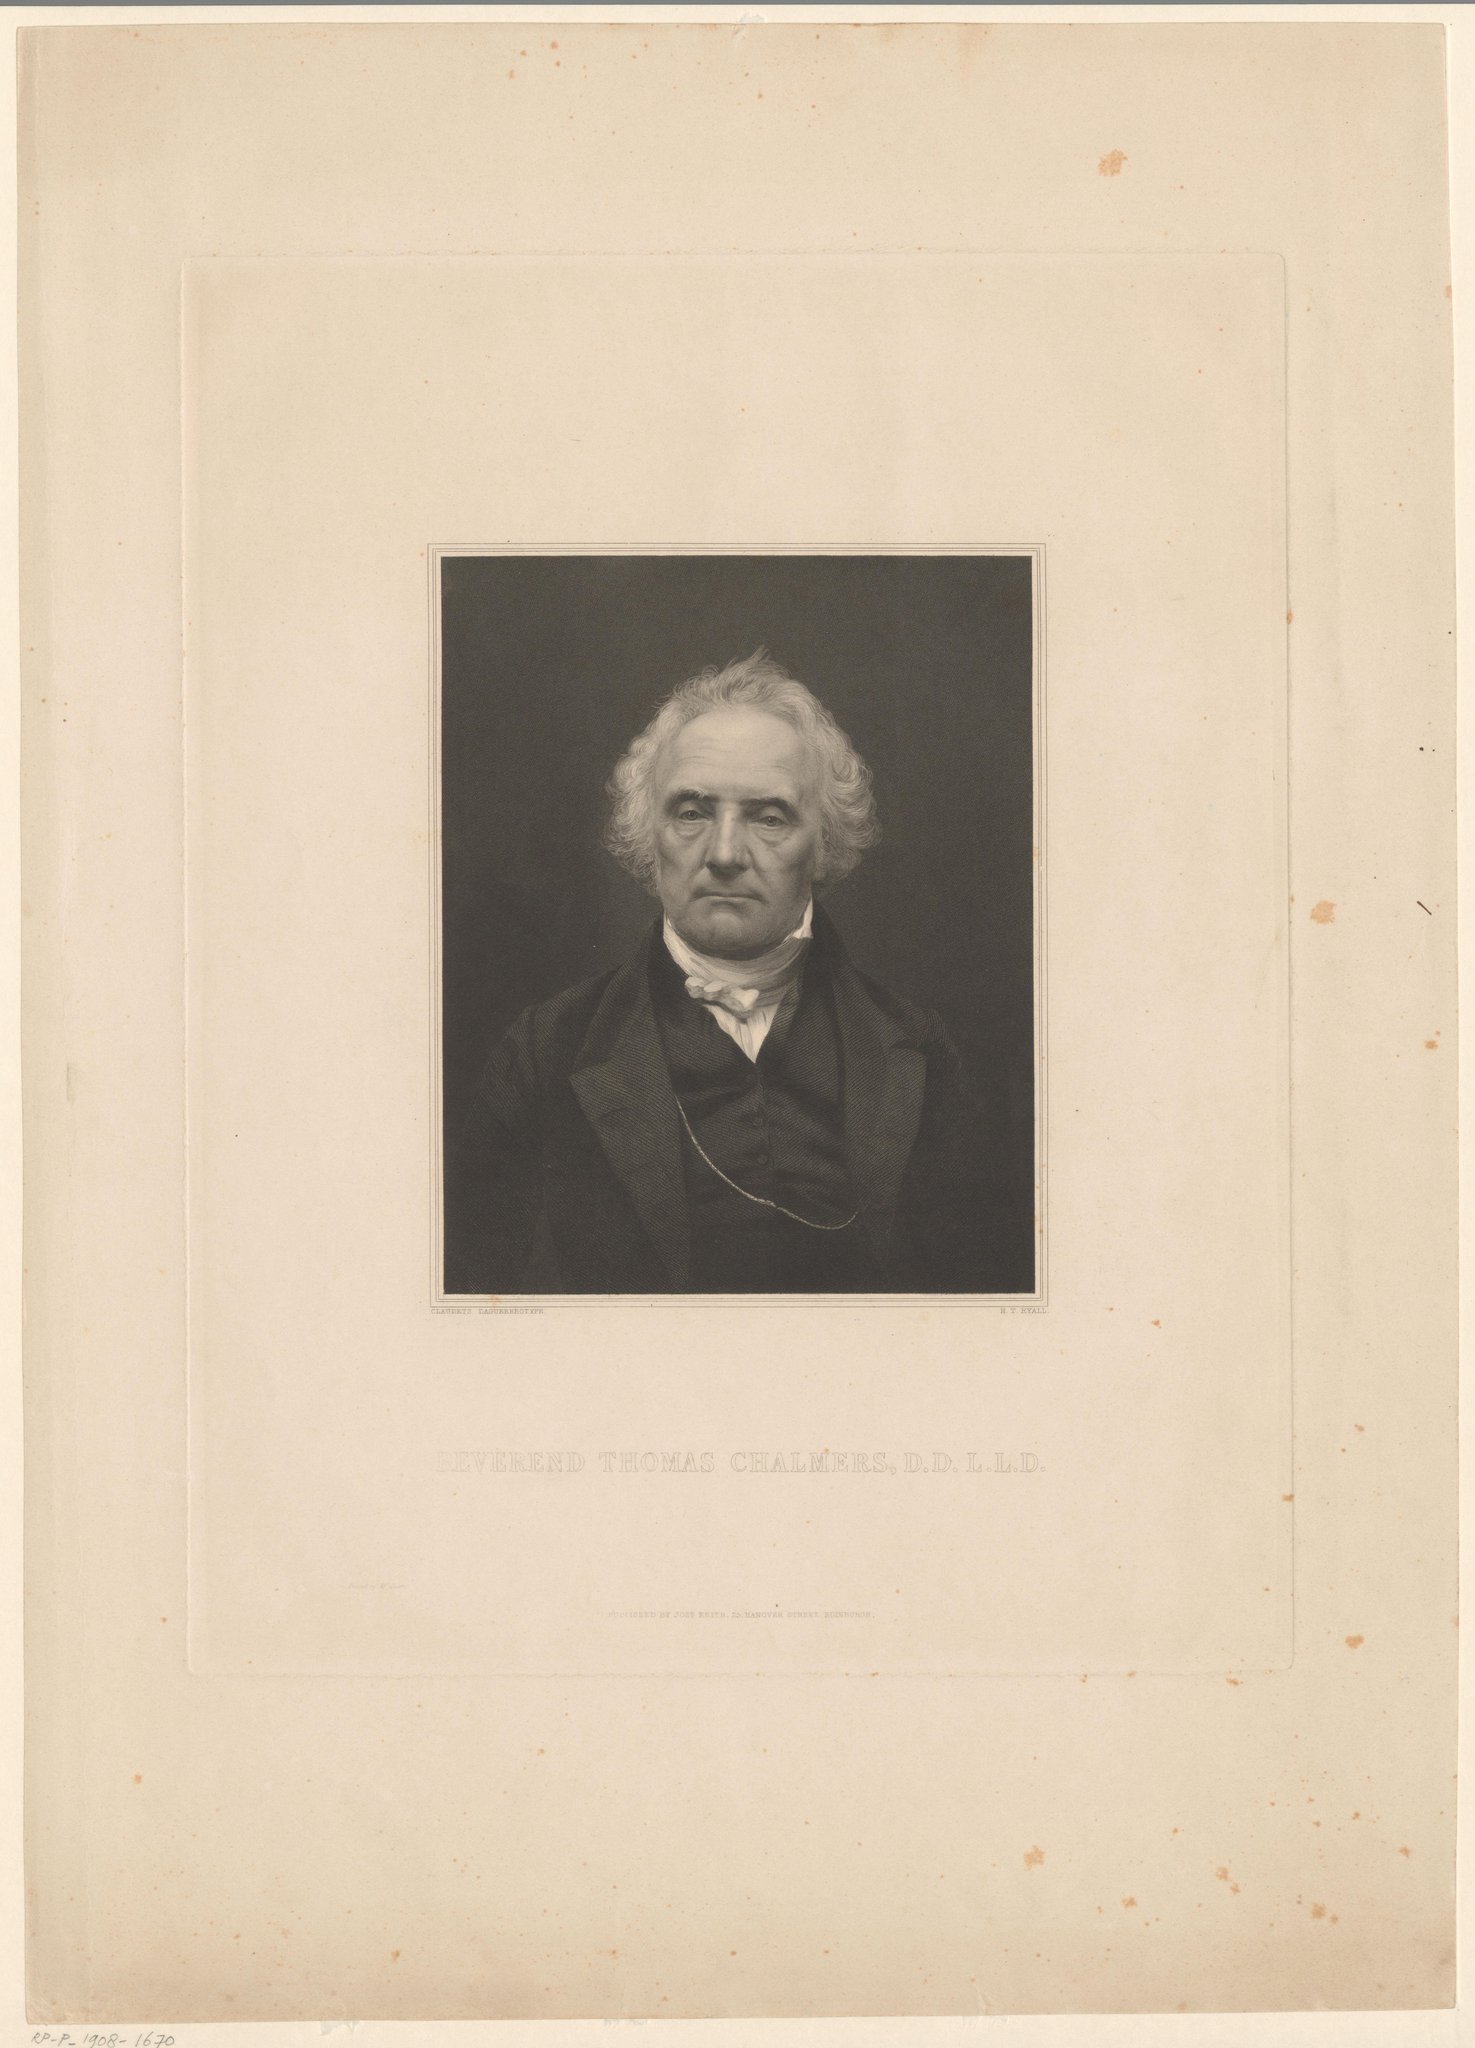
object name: print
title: Portret van Thomas Chalmers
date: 1821-1867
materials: paper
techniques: engraving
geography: edinburgh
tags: historical persons, politician, e.g. party leader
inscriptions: collector's mark: Lugt 2228